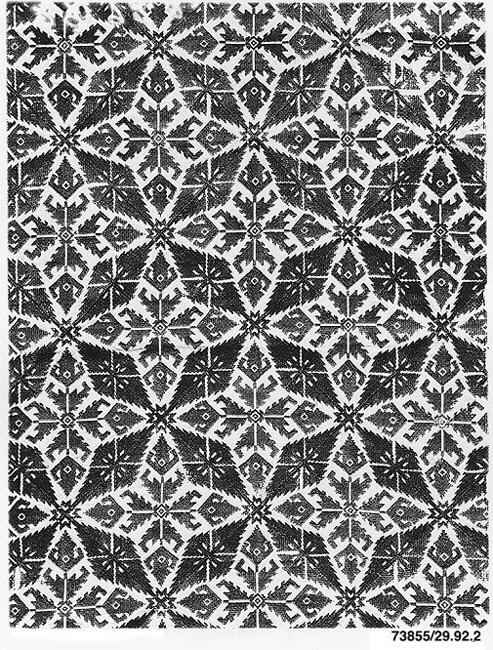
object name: fragment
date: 1701-1800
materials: linen, silk